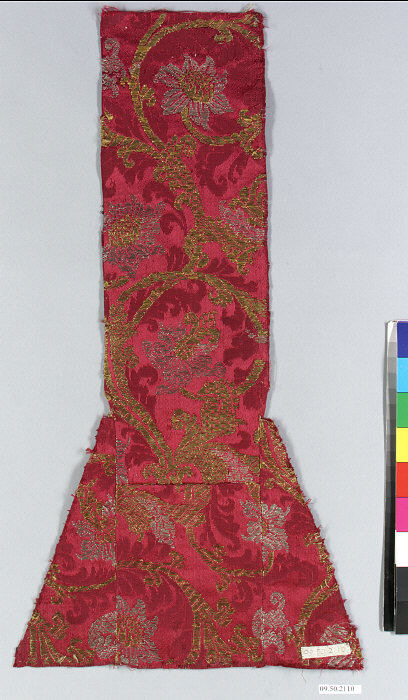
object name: maniple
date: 1695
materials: metal thread, silk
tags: flowers